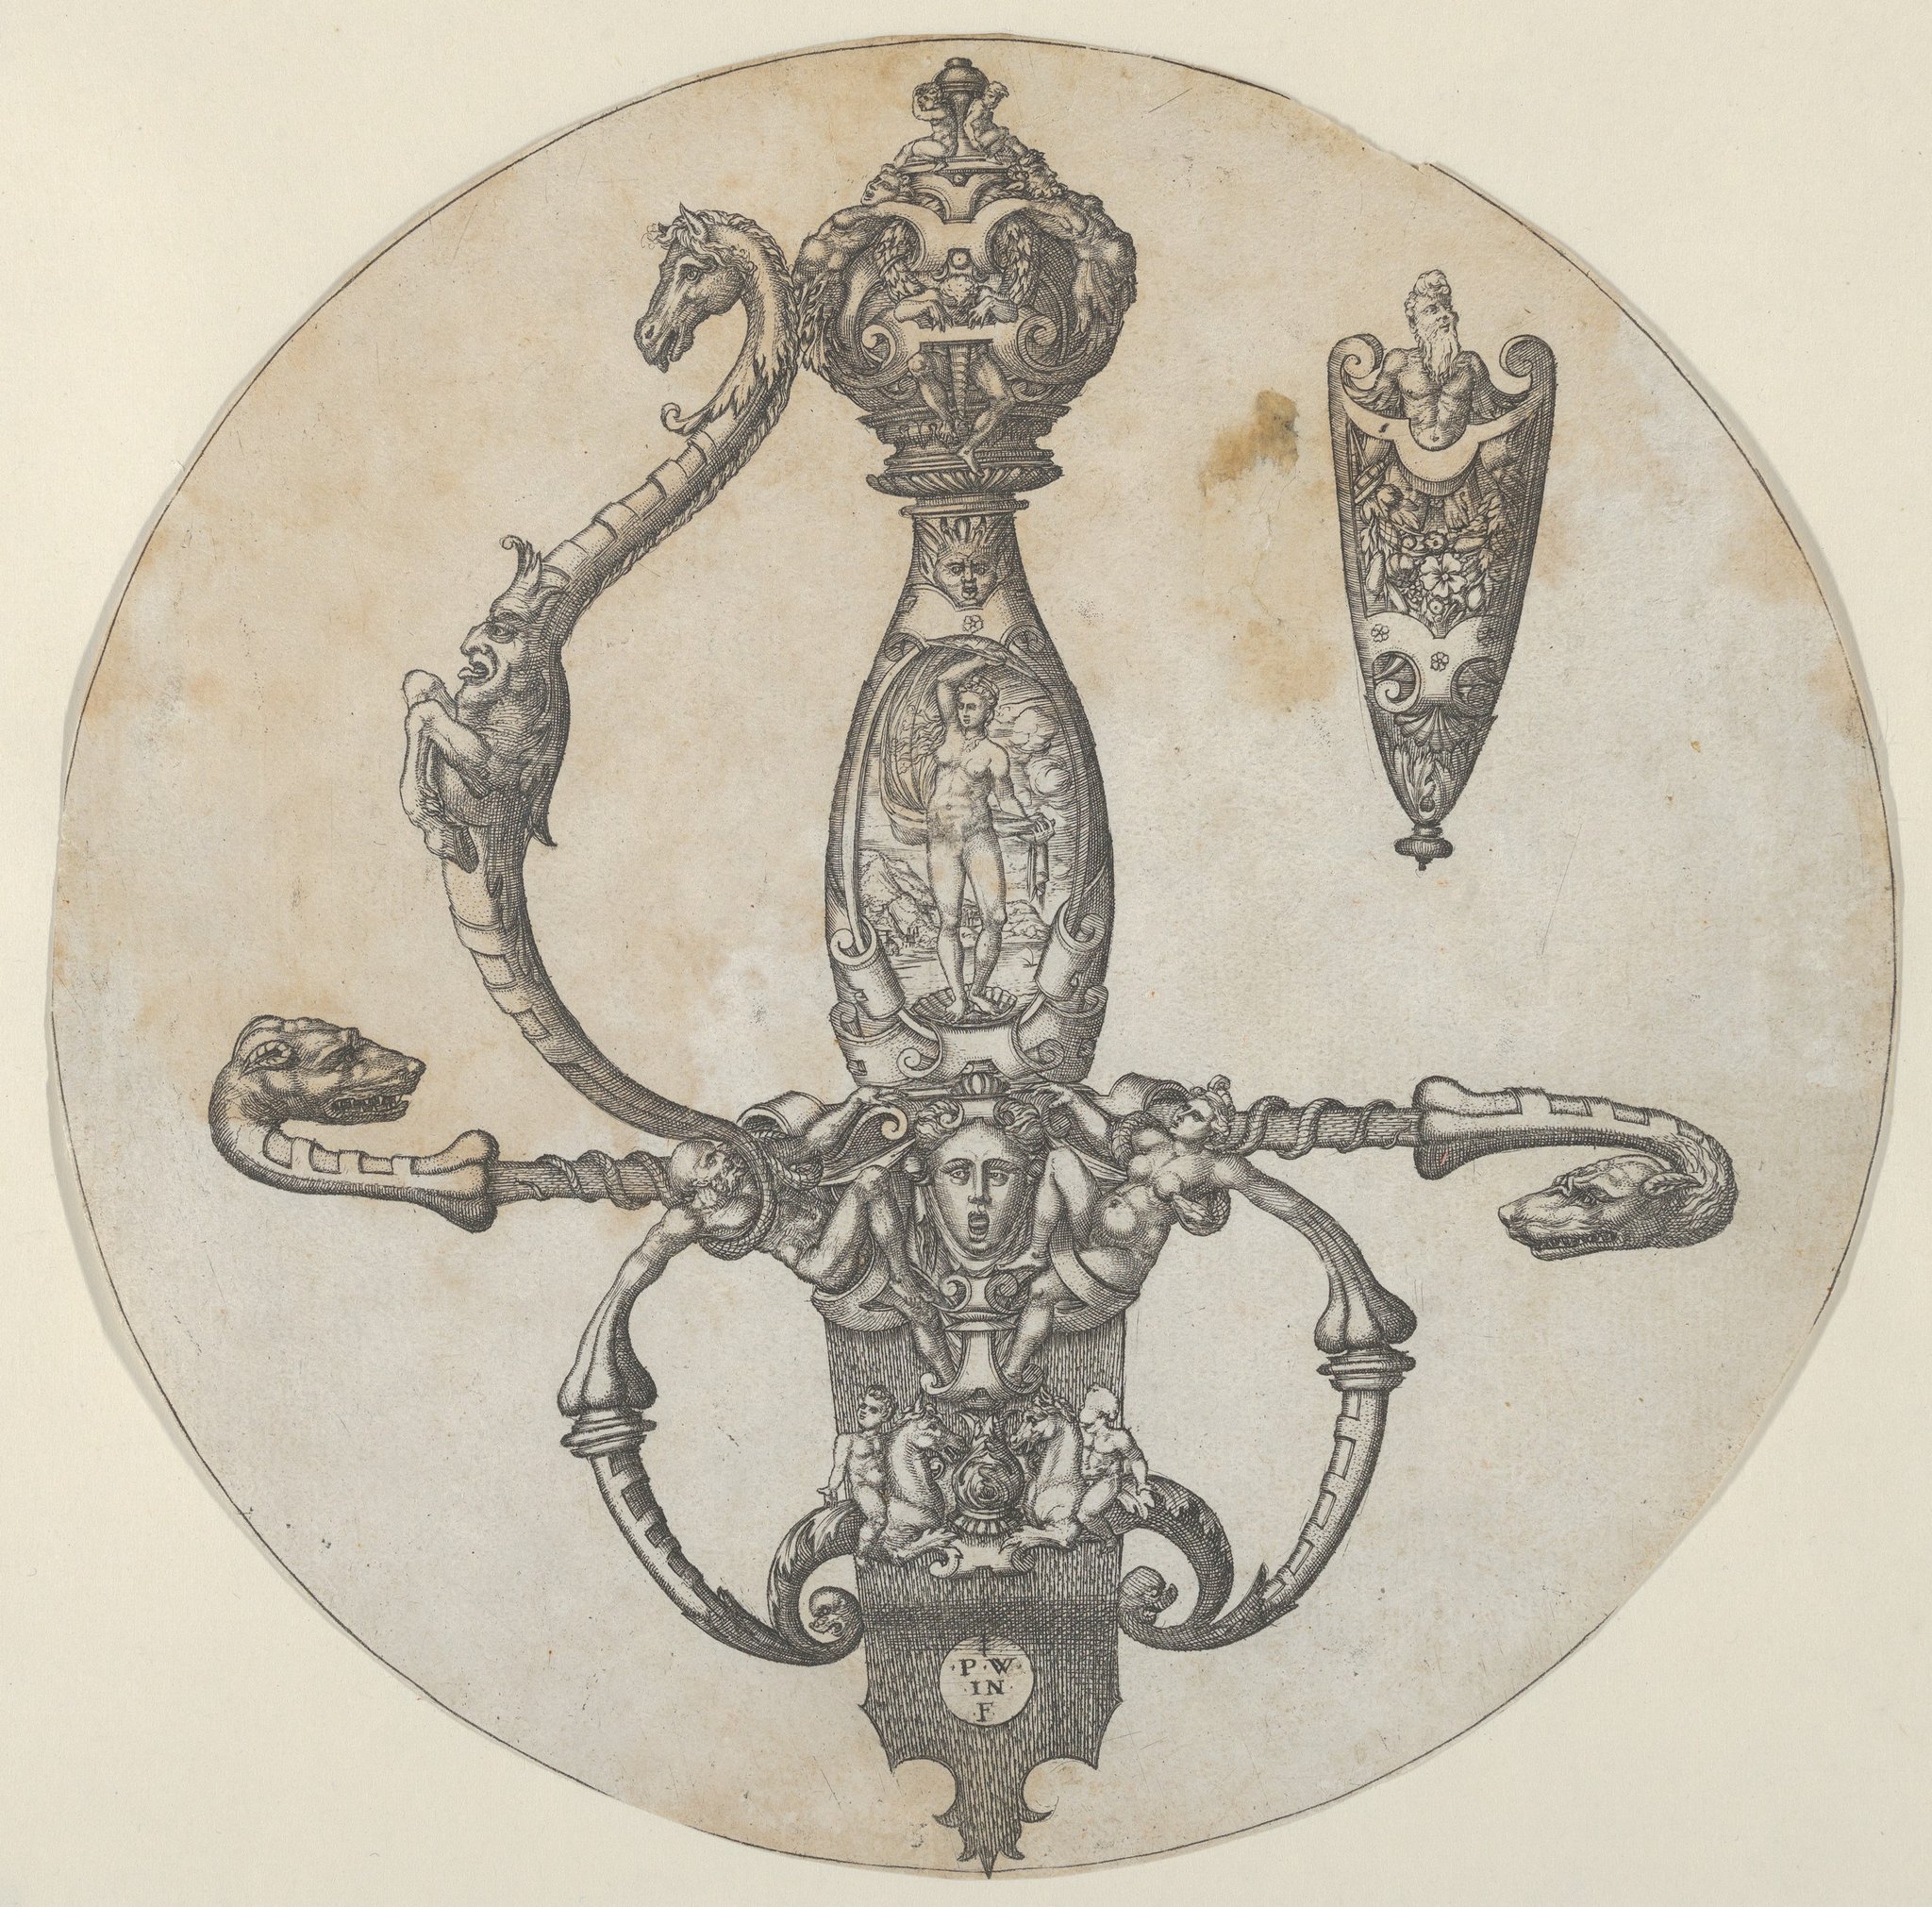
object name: print ornament architecture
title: Design for a Sword Hilt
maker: pierre woeiriot de bouzey ii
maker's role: artist and engraver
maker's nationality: french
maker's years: 1532-1599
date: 1550-1560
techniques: engraving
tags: hilts,ornament,mythical creatures